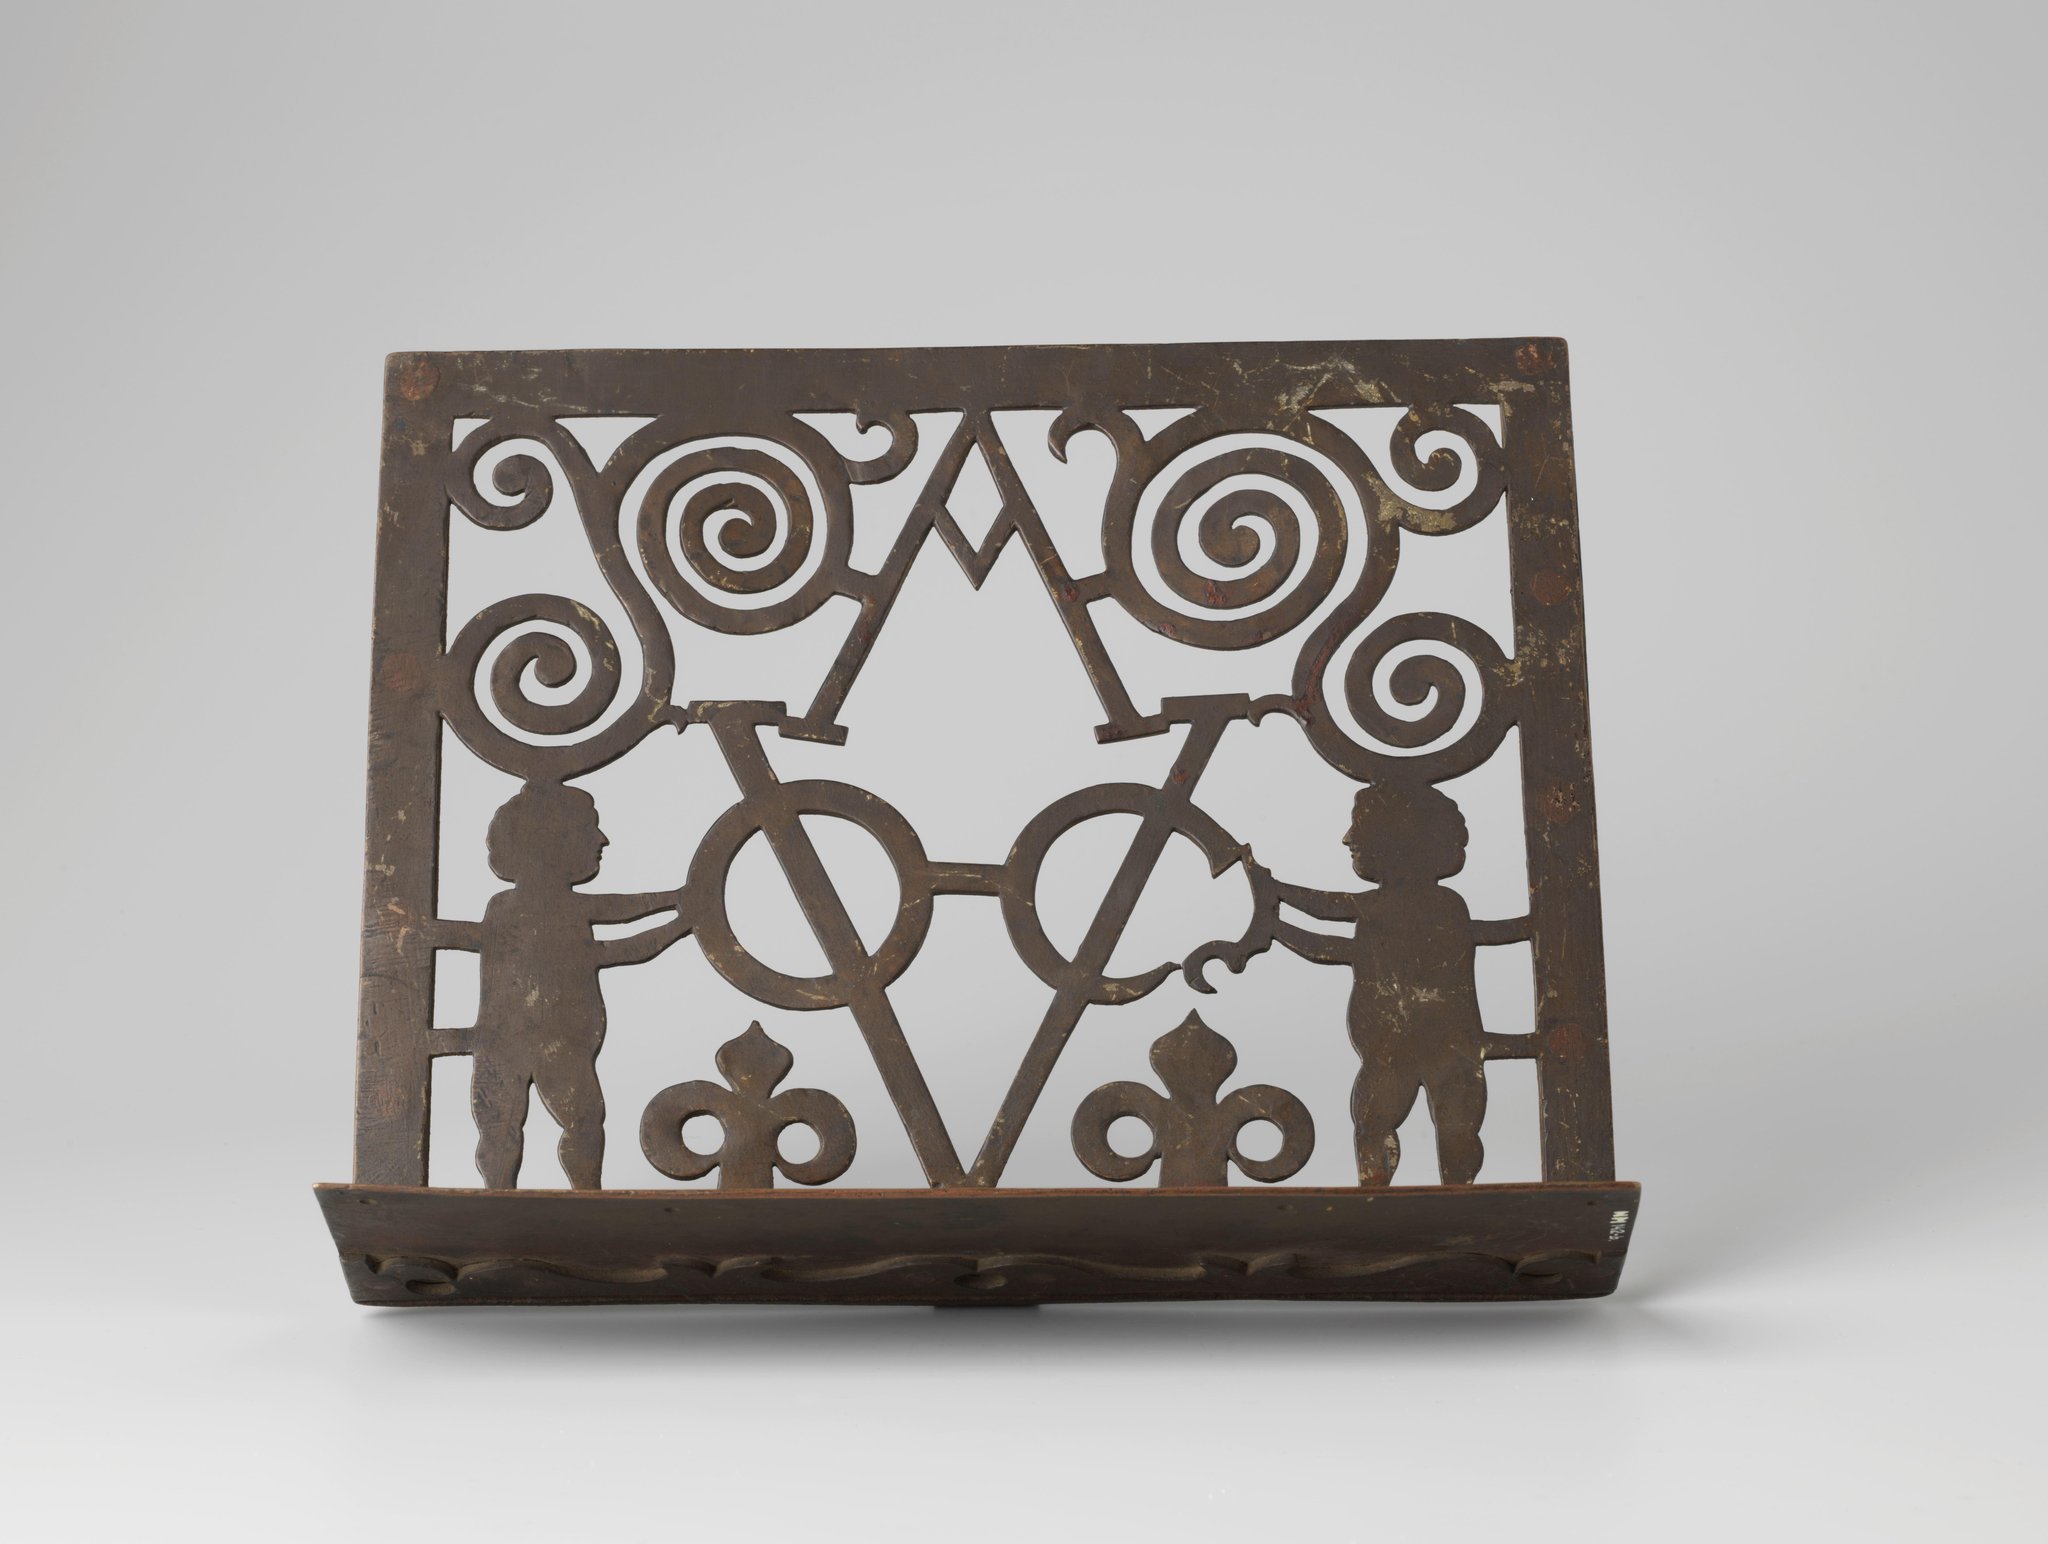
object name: standaard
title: Standaard horend bij een lessenaar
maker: Anonymous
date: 1700-1800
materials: iron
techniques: forging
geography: amsterdam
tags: amsterdam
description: IJzeren standaard horend bij een lessenaar.